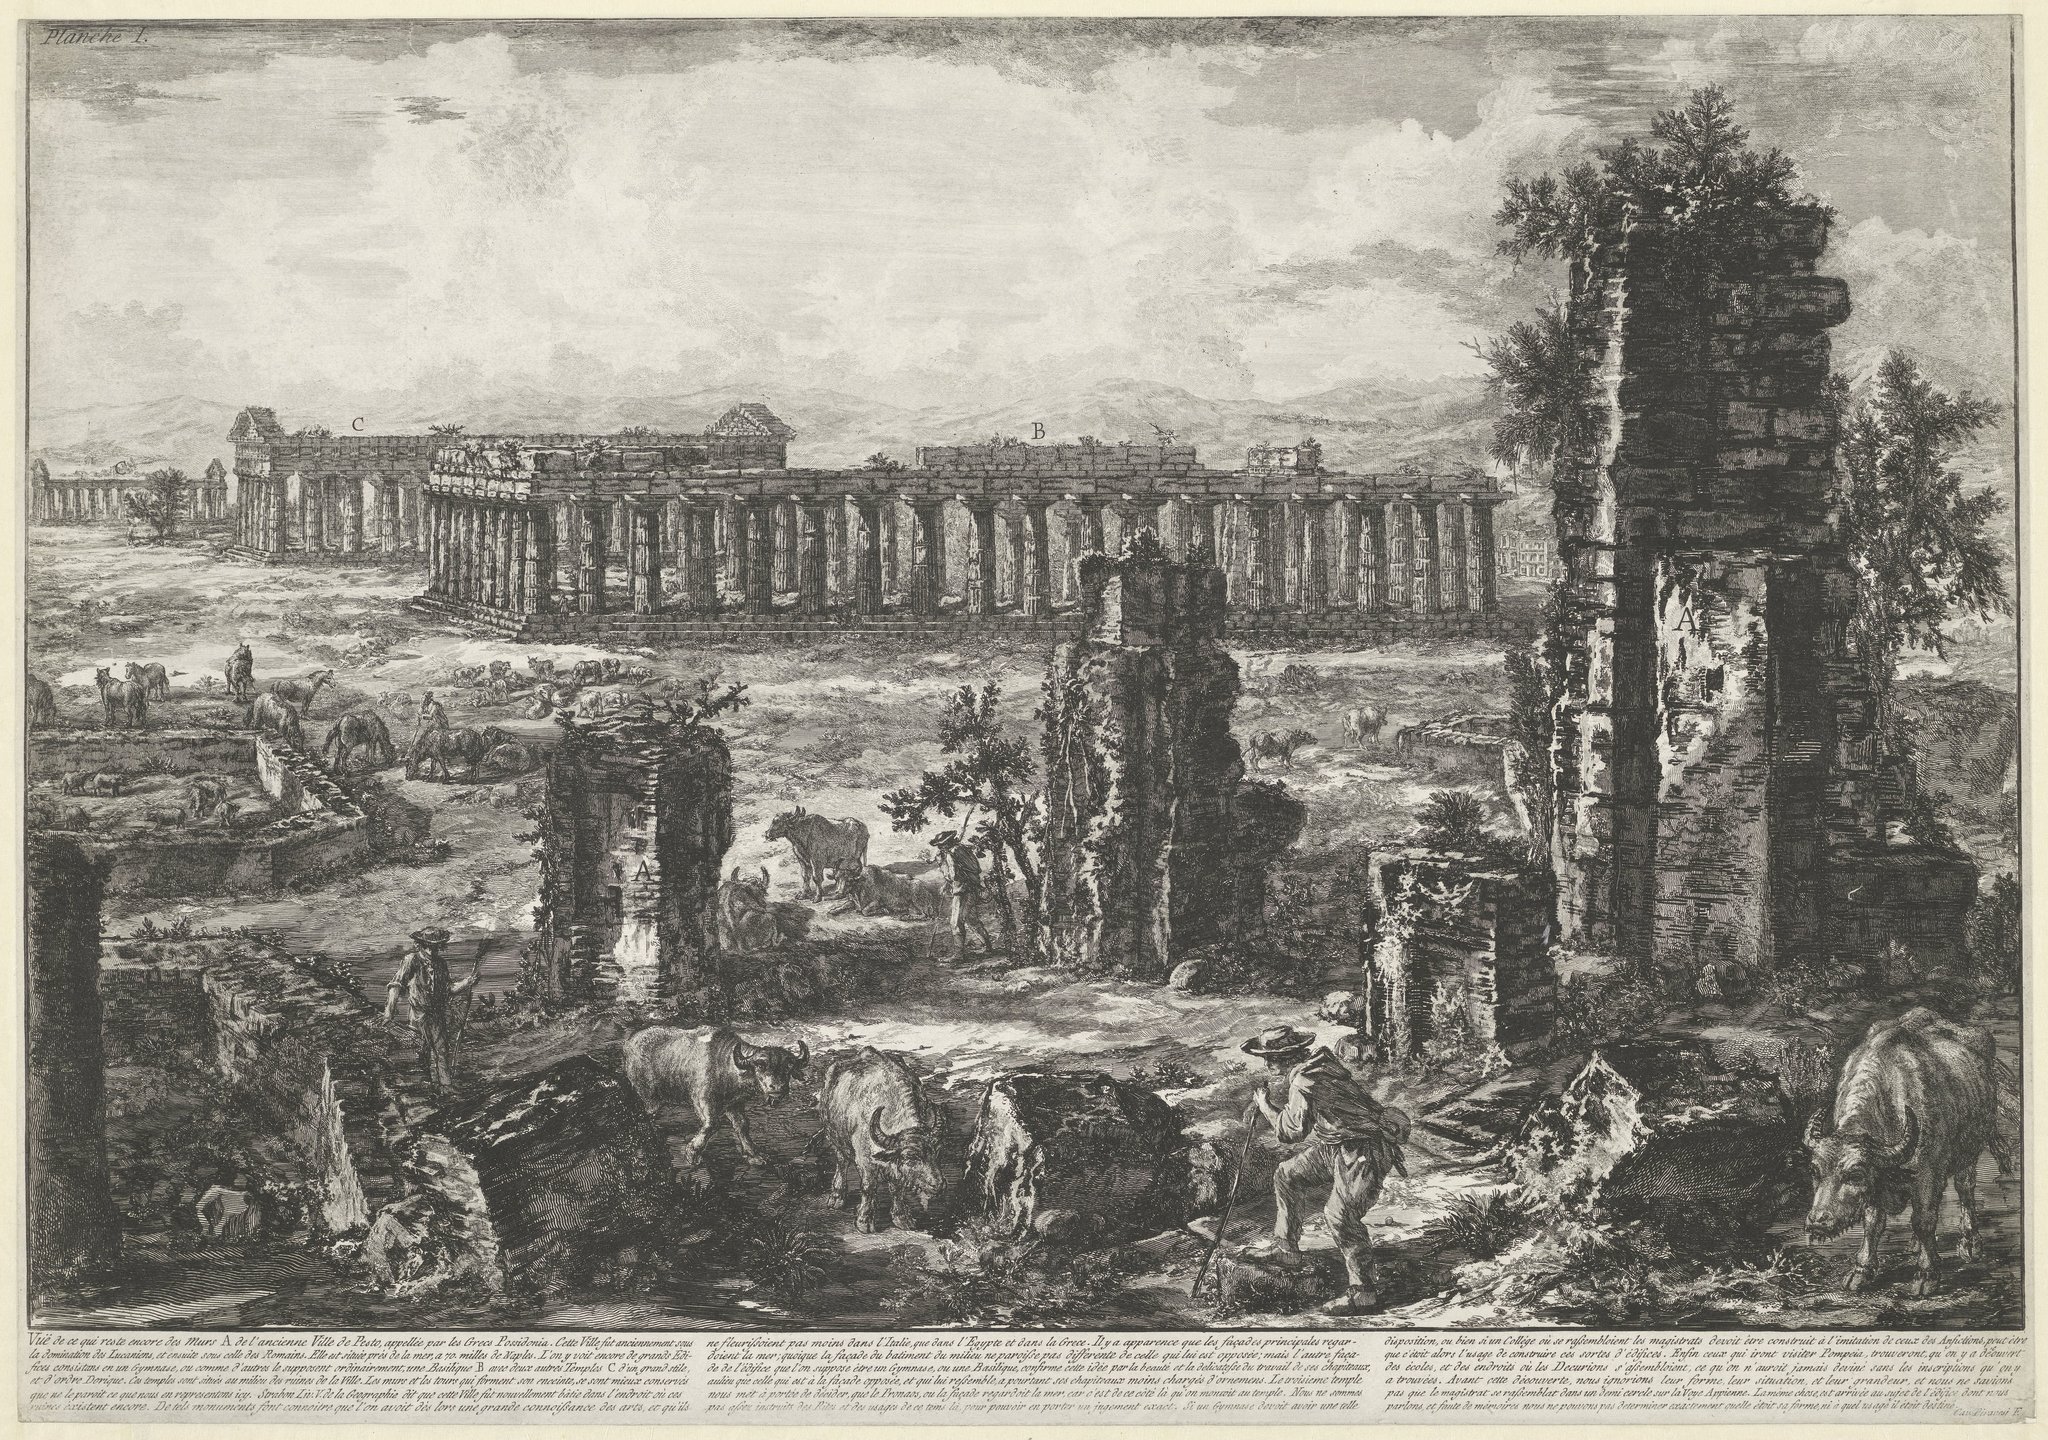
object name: print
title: Oude stadsmuur en tempels te Paestum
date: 1778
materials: paper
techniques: etching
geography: rome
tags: ruin of a building ~ architecture, landscape with ruins, city-walls, temple, shrine ~ roman religion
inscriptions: collector's mark: Lugt 2760, collector's mark: Lugt 2228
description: Deze prent maakt deel uit van een reeks van 20 prenten (+ titelprent) met gezichten op tempels te Paestum. De gebouwen en de vegetatie op de prenten zijn uitgevoerd door Giovanni Battista Piranesi. De figuren zijn mogelijk uitgevoerd door zijn zoon Francesco.